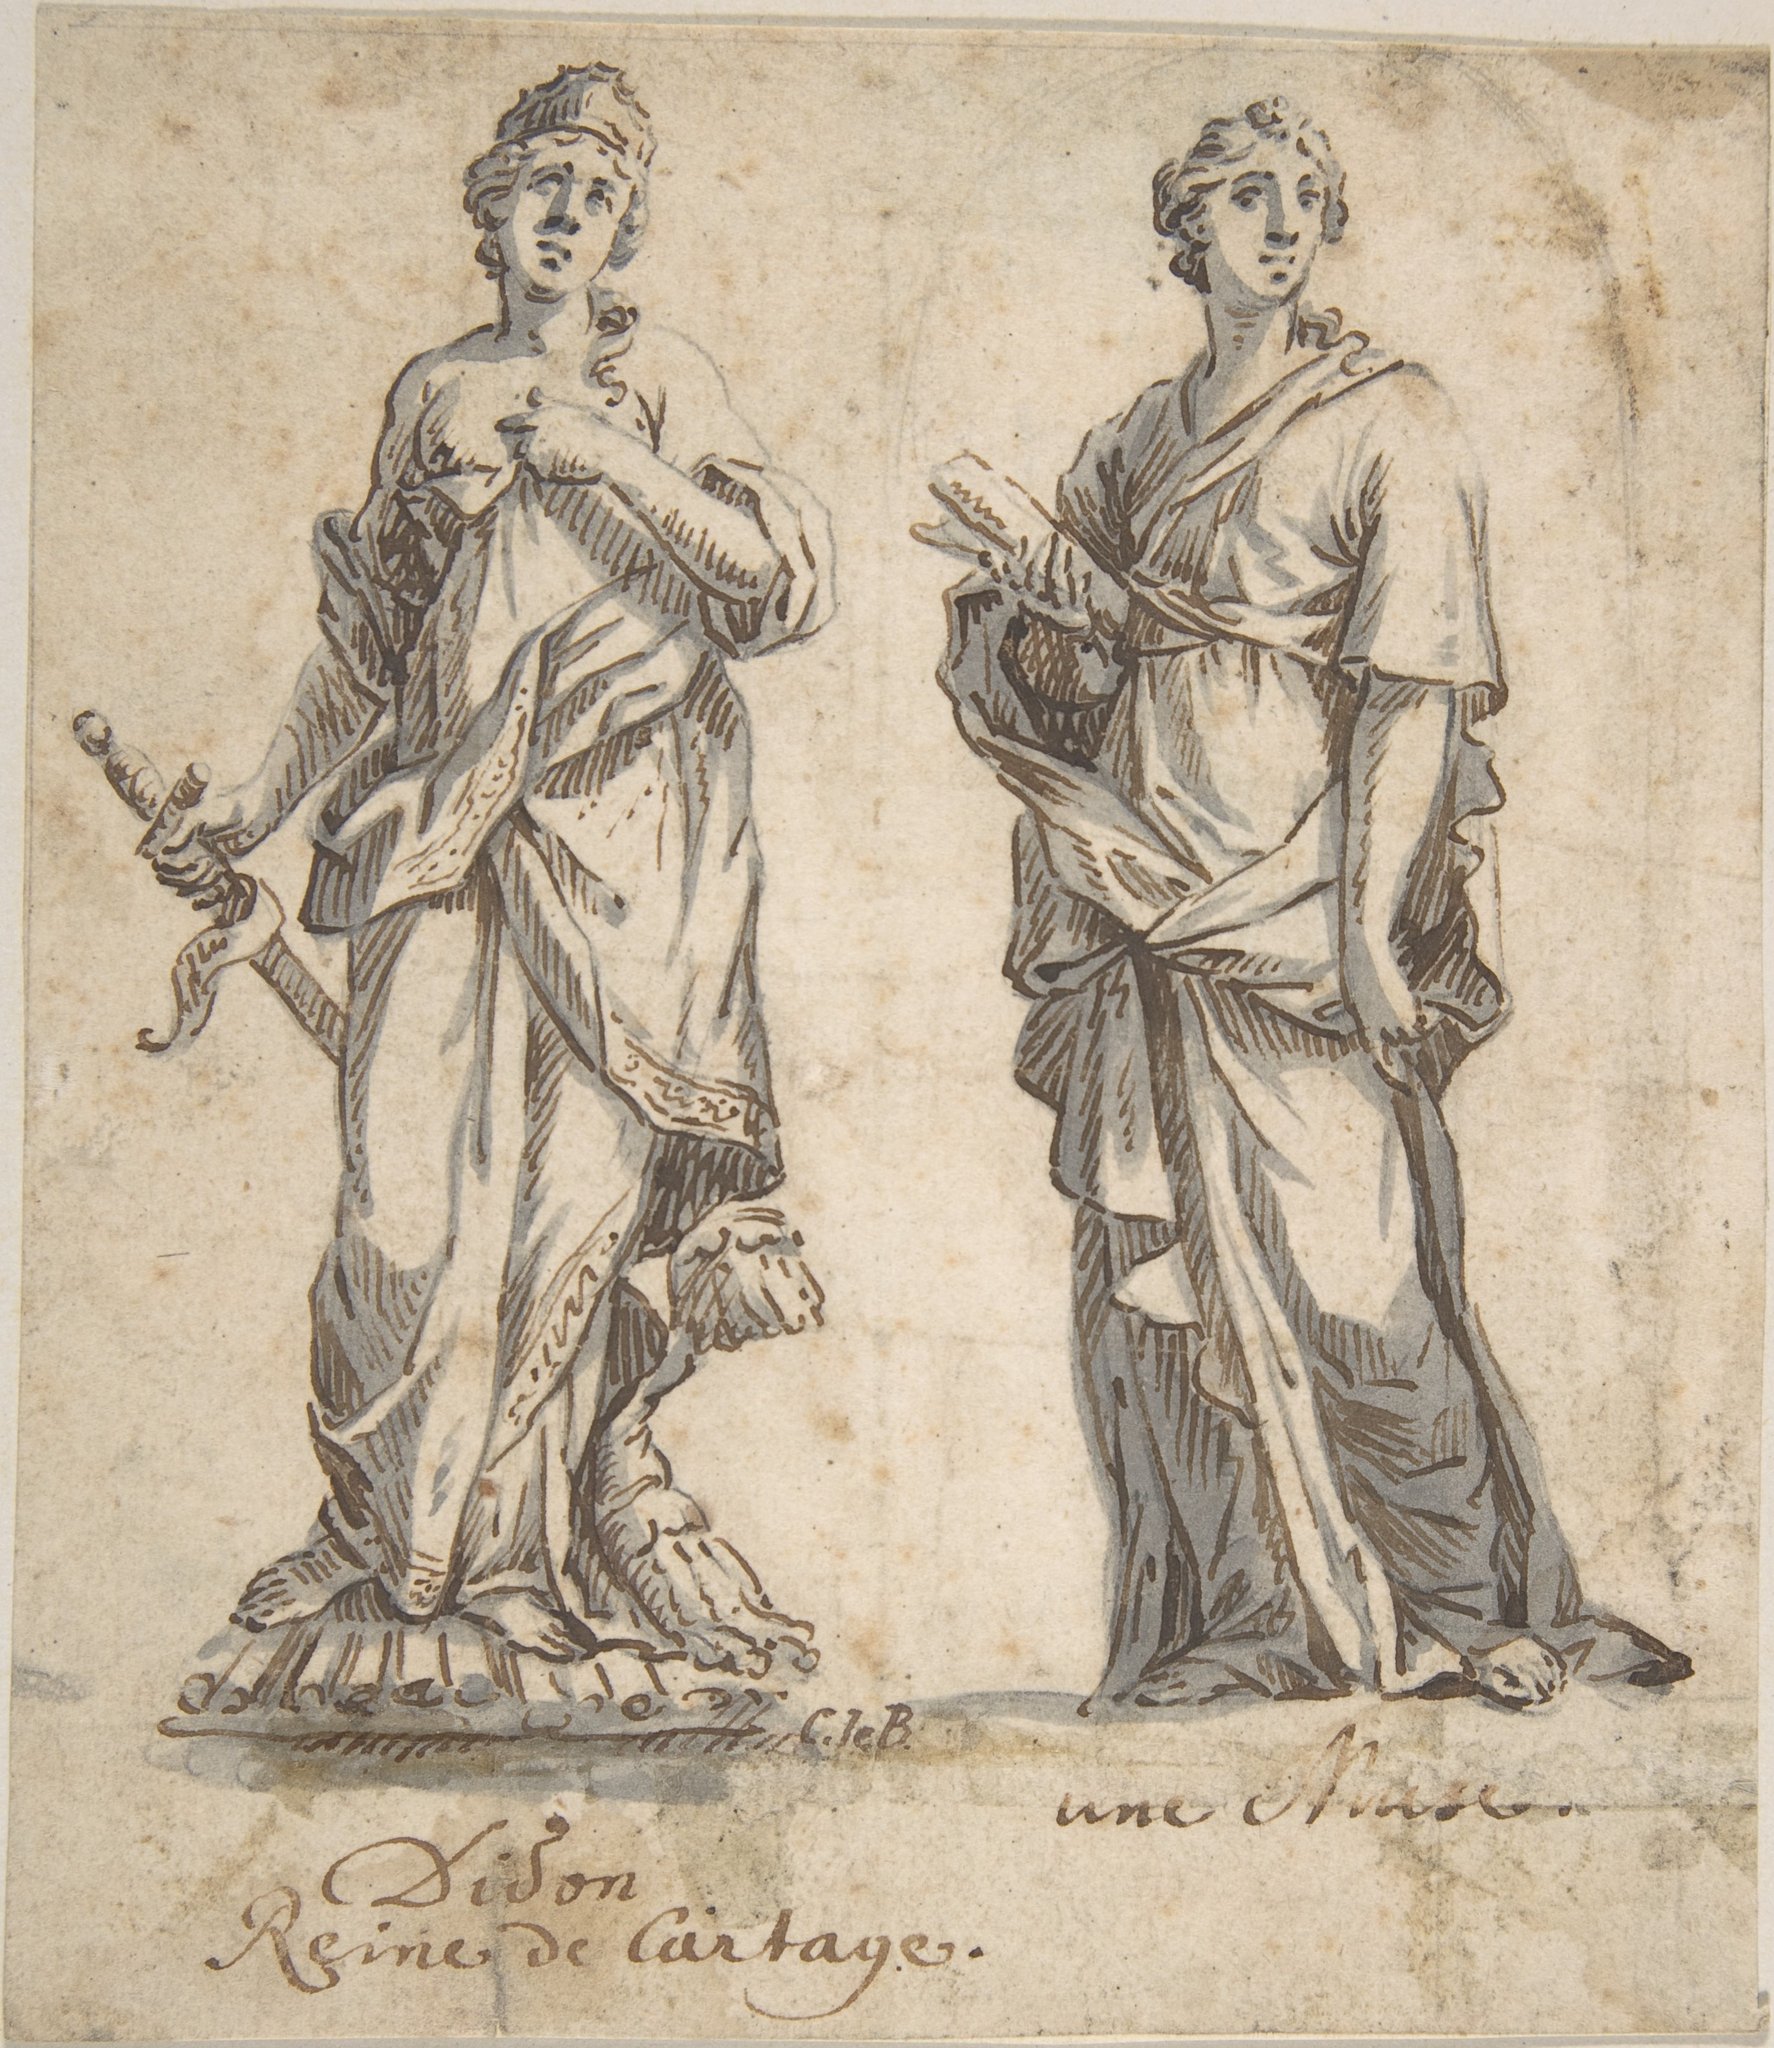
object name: drawing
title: Dido Reine de Cartage/ une Muse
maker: anonymous, french, 17th century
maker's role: artist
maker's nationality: french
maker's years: 1600-1700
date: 1601-1700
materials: graphite, ink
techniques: brush, pen, wash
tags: swords,queens,muses